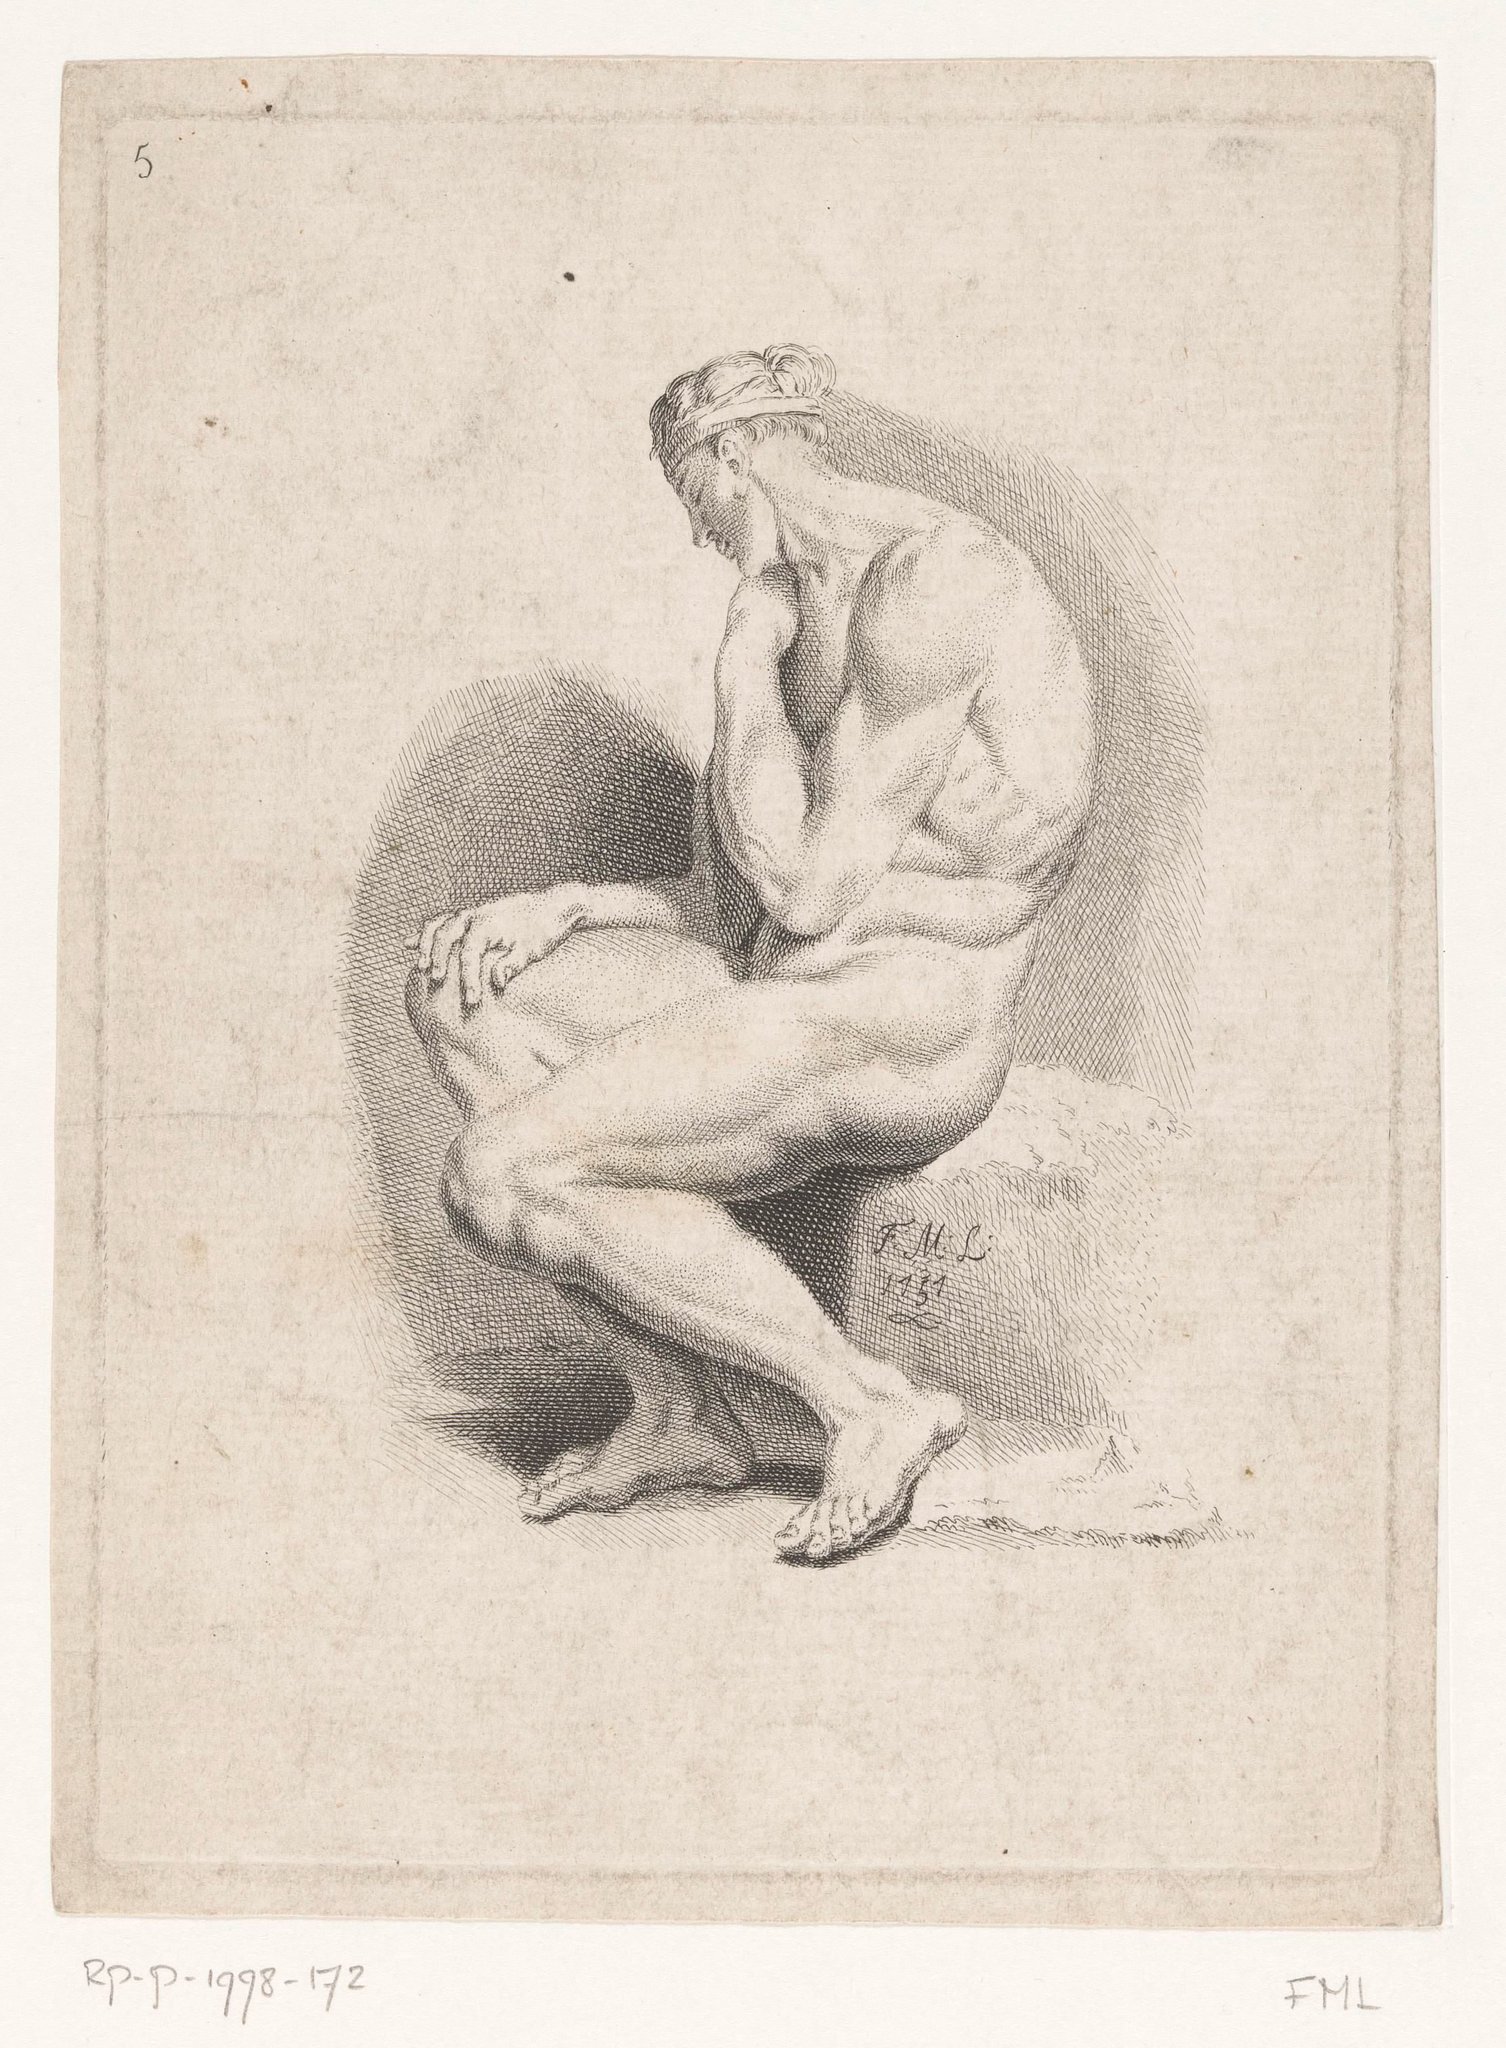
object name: print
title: Zittende naakte man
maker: monogrammist fml (prentmaker)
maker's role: print maker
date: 1751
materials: paper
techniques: engraving, etching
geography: netherlands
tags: sitting figure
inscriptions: date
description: Figuurstudie van een zittende naakte man op een steen, in een peinzende houding naar links gedraaid.